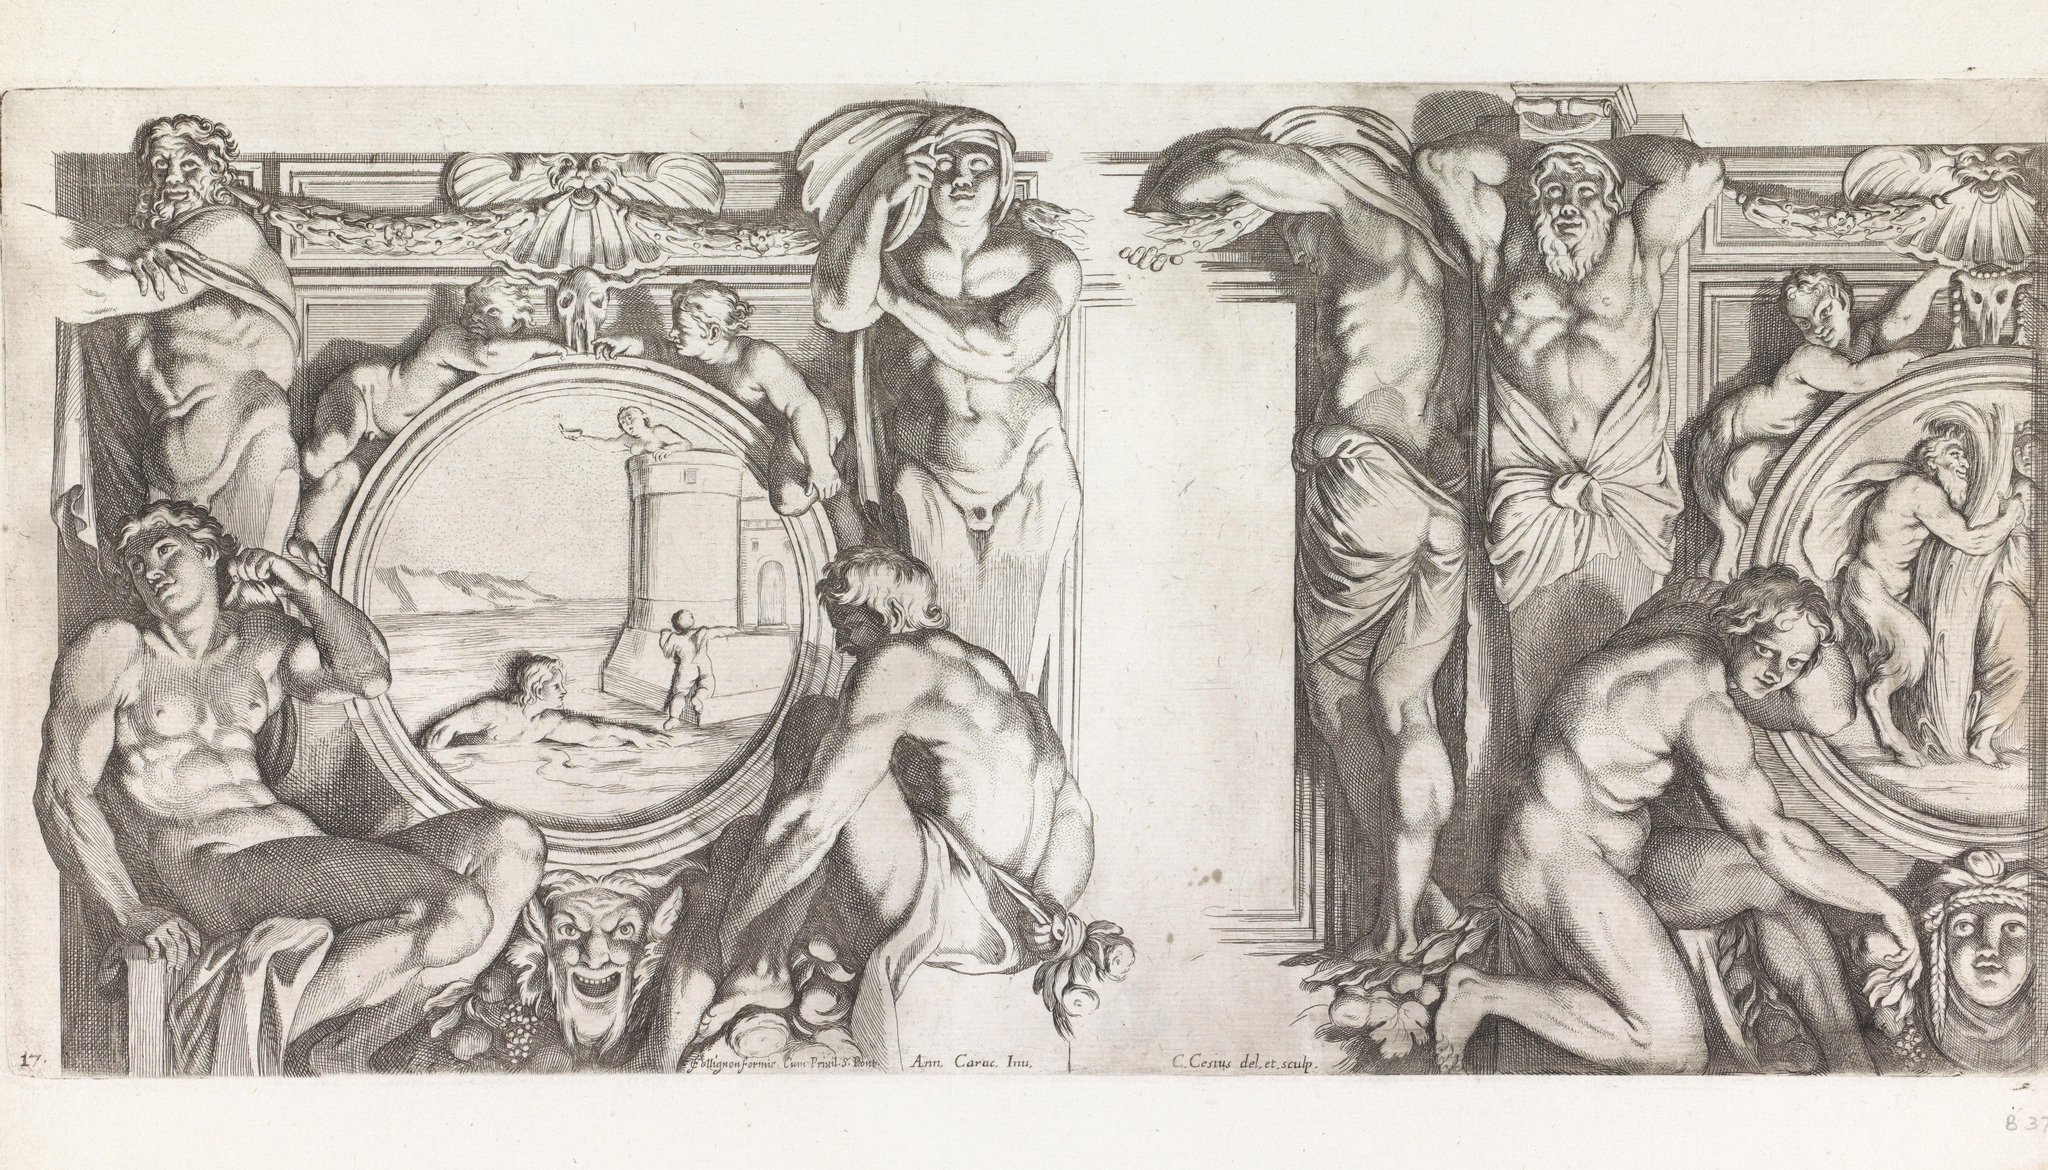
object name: print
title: Schilderingen in Palazzo Farnese te Rome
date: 1656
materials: paper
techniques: etching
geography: rome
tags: the (nude) human figure; 'corpo humano' (ripa), leander swims across the hellespont at night, usually guided by a torch reared upon a tower by hero, (story of) hero and leander, cupids: 'amores', 'amoretti', 'putti', syrinx changed into a reed: while fleeing from pan, the nymph syrinx is changed into reed by her sisters, the naiads (ovid, metamorphoses i 705)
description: Links een medaillon met een voorstelling van Leander die naar Hero zwemt over de Hellespont. Rond het medaillon sculpturen van naakte figuren, putti en een masker. Rechts een medaillon met een voorstelling van Pan die Syrinx achtervolgt tussen het riet. Rond het medaillon sculpturen van naakte figuren, putti en een masker.